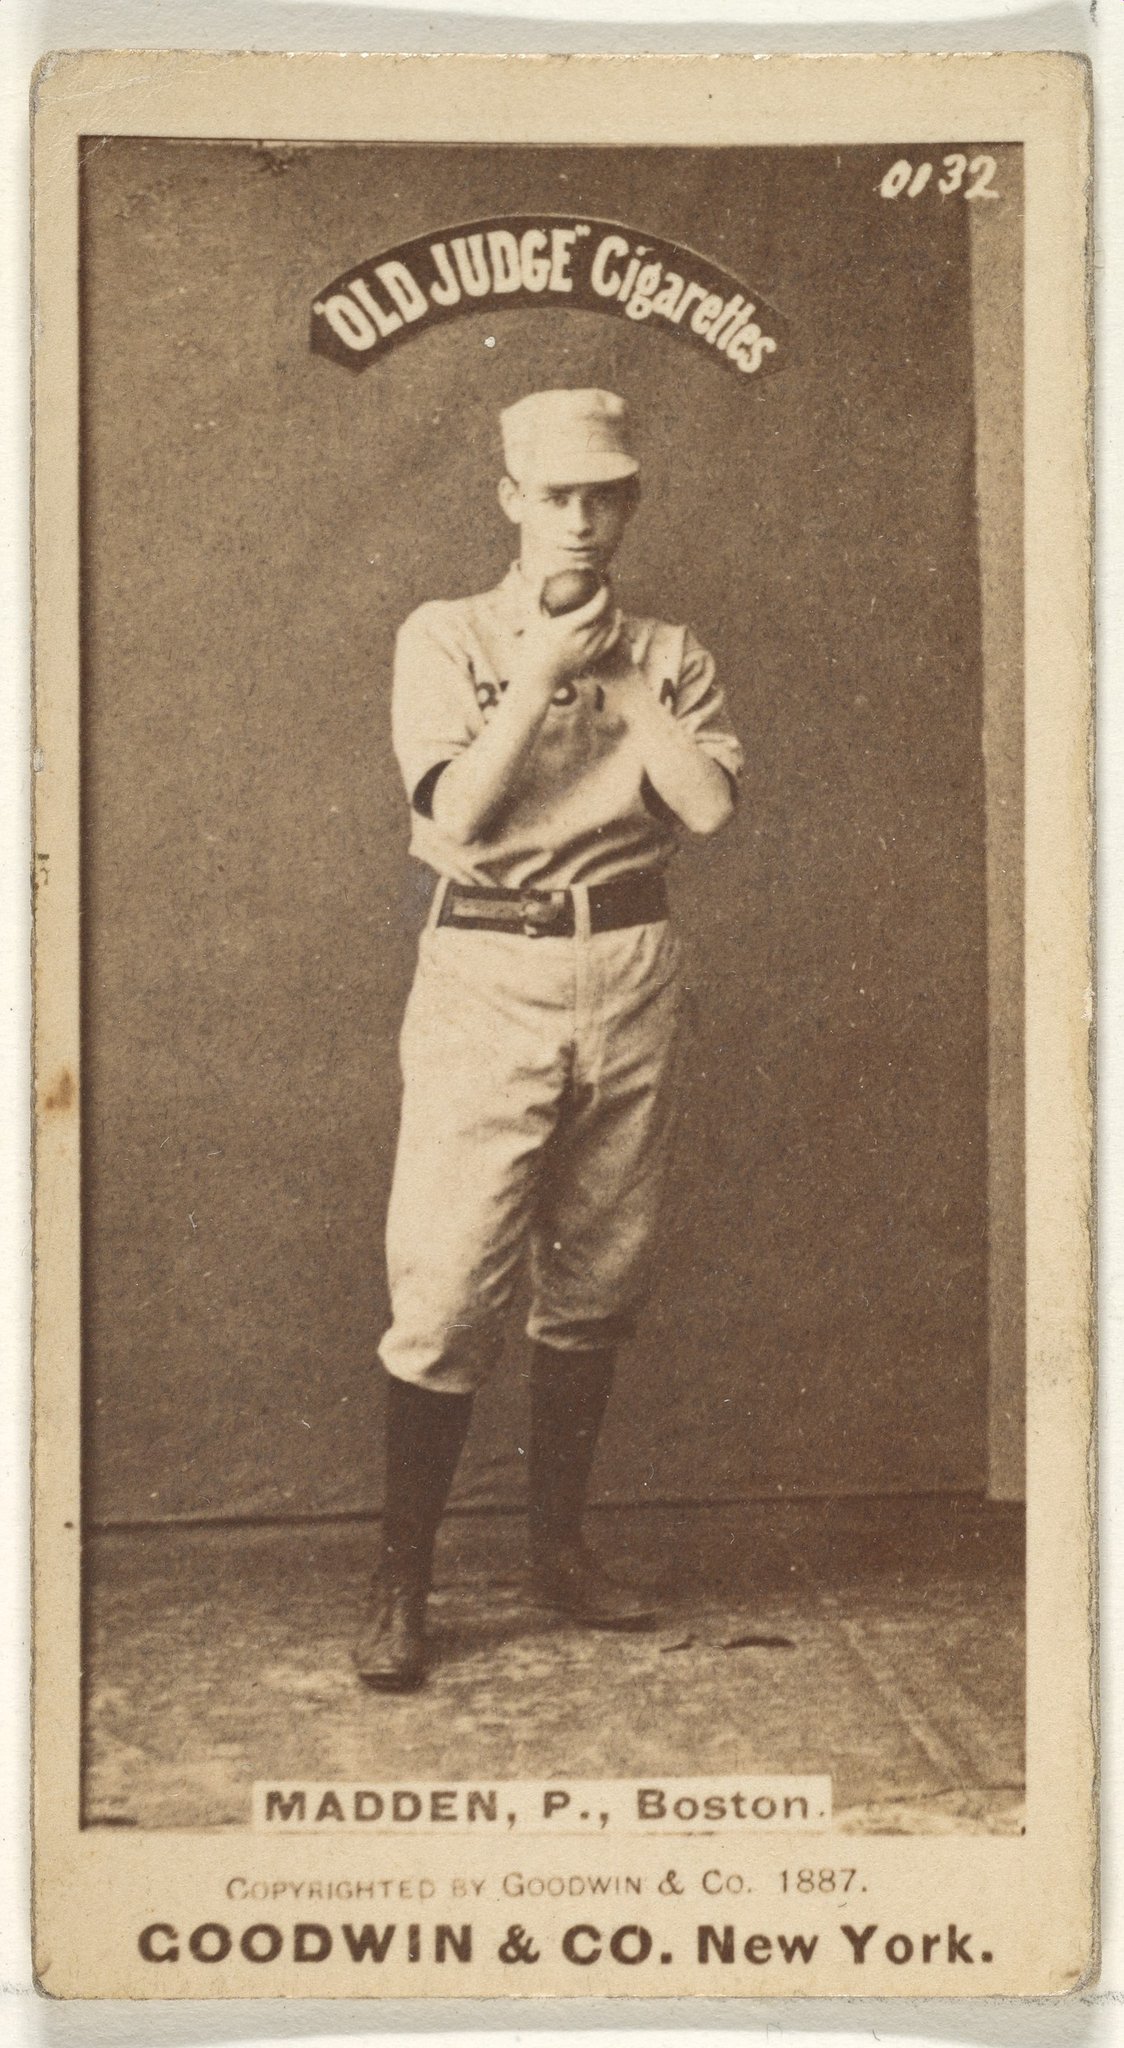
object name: baseball card, photograph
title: Madden, Pitcher, Boston, from the Old Judge series (N172) for Old Judge Cigarettes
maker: goodwin & company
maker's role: publisher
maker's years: 1850-1950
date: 1887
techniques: albumen silver print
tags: men,portraits,baseball,athletes